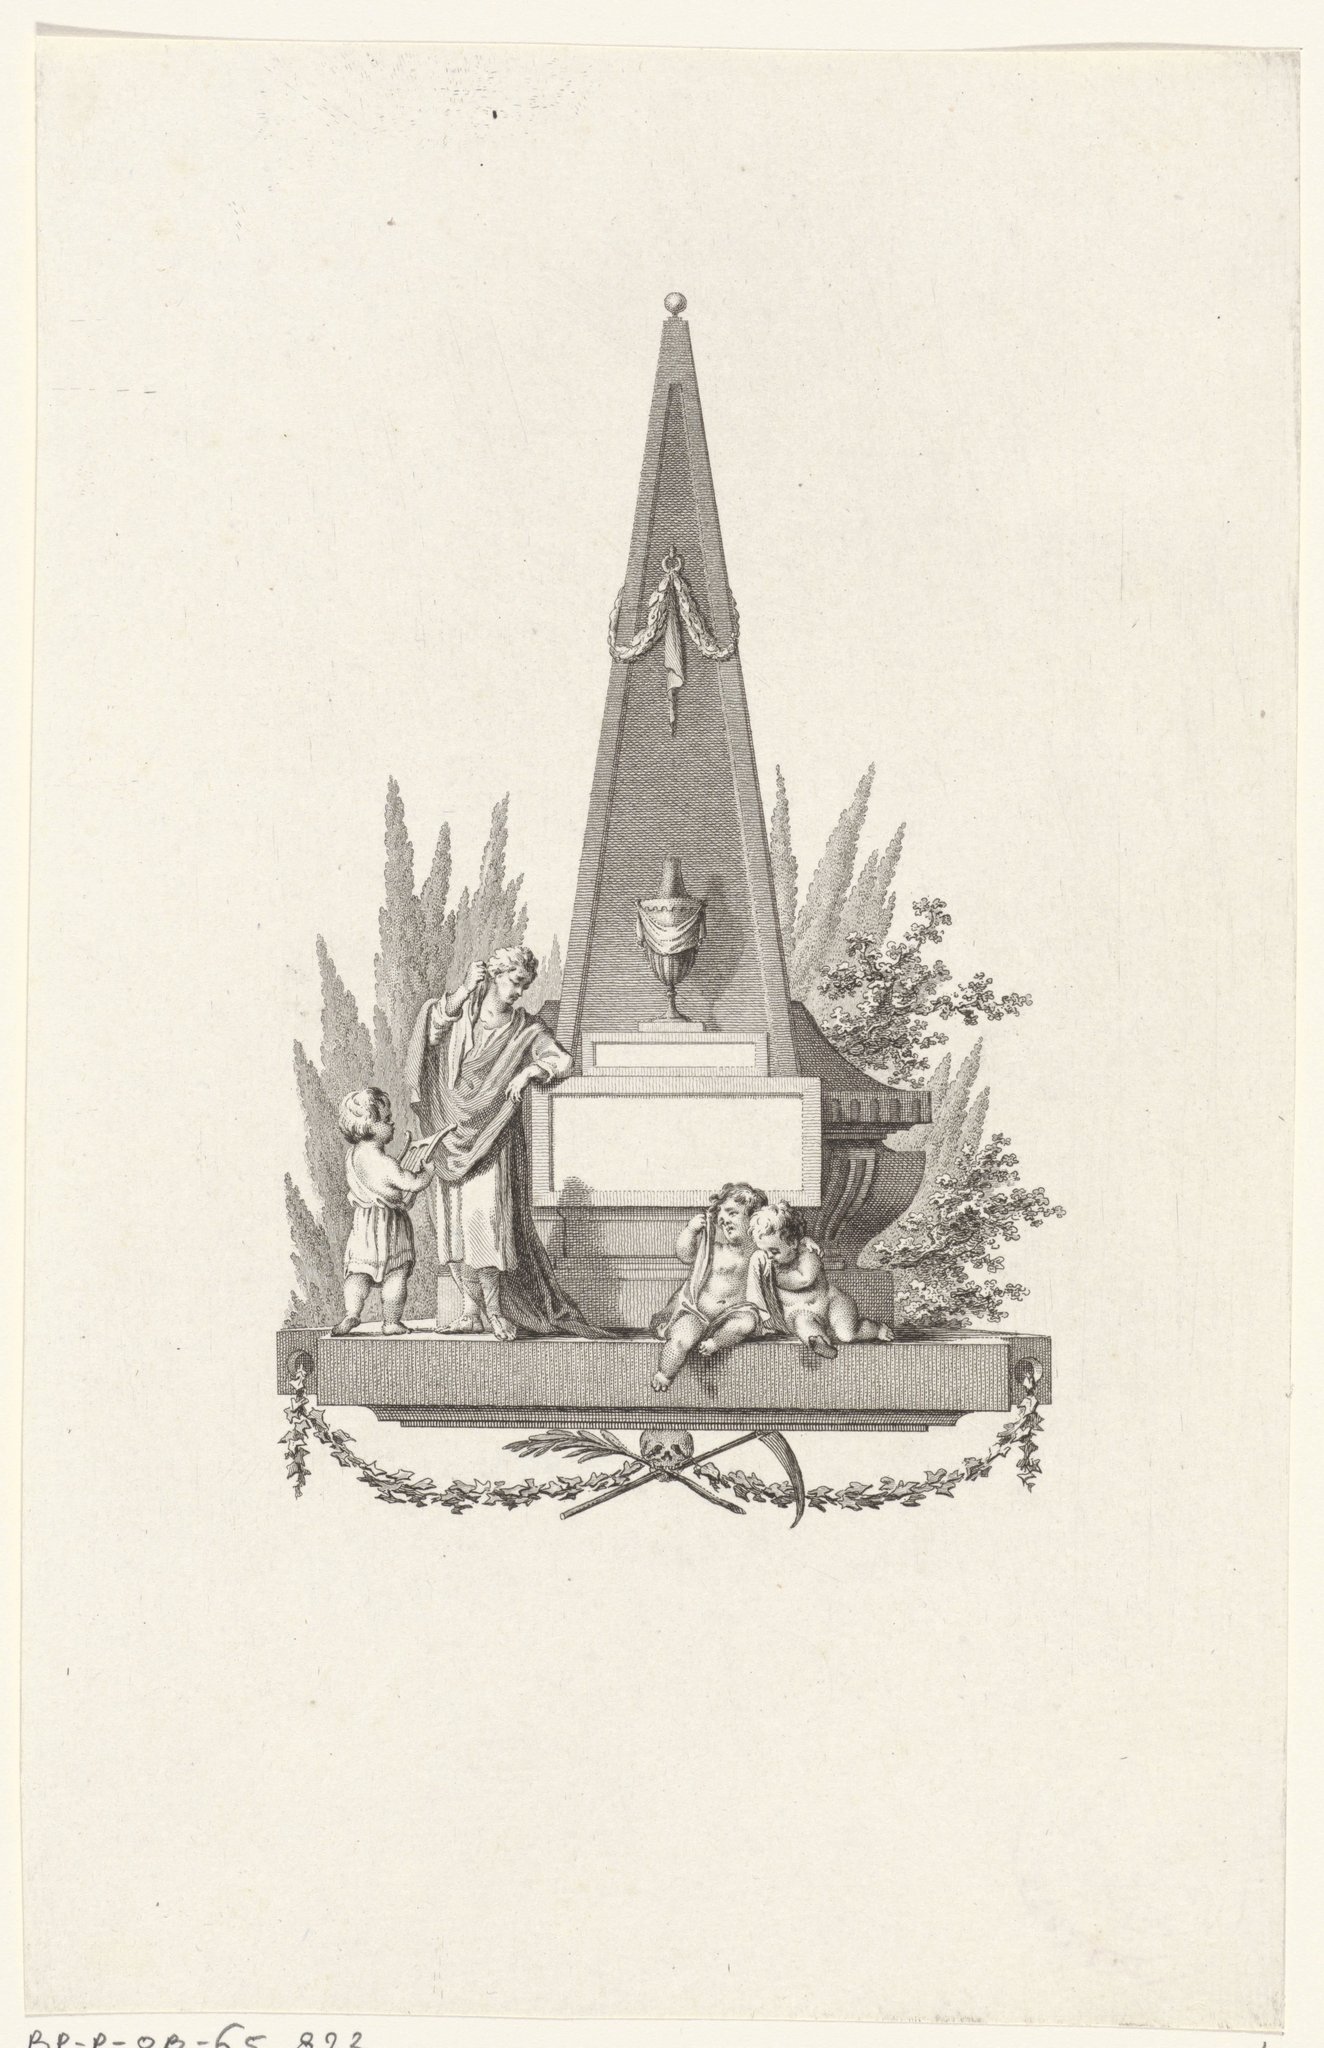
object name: print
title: Titelpagina voor: Hiëronimus van Alphen, 'Gedigten en Overdenkingen', 1777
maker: reinier vinkeles (i)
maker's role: draughtsman, print maker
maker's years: 1741-1816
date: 1777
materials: paper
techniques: engraving, etching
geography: amsterdam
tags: mourning the dead, grave-building, monumental tomb, cupids: 'amores', 'amoretti', 'putti'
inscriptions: collector's mark: Lugt 240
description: Proefdruk van titelpagina voor: Alphen, Hiëronimus van. Gedigten en Overdenkingen. Utrecht: Jan van Terveen, 1777.